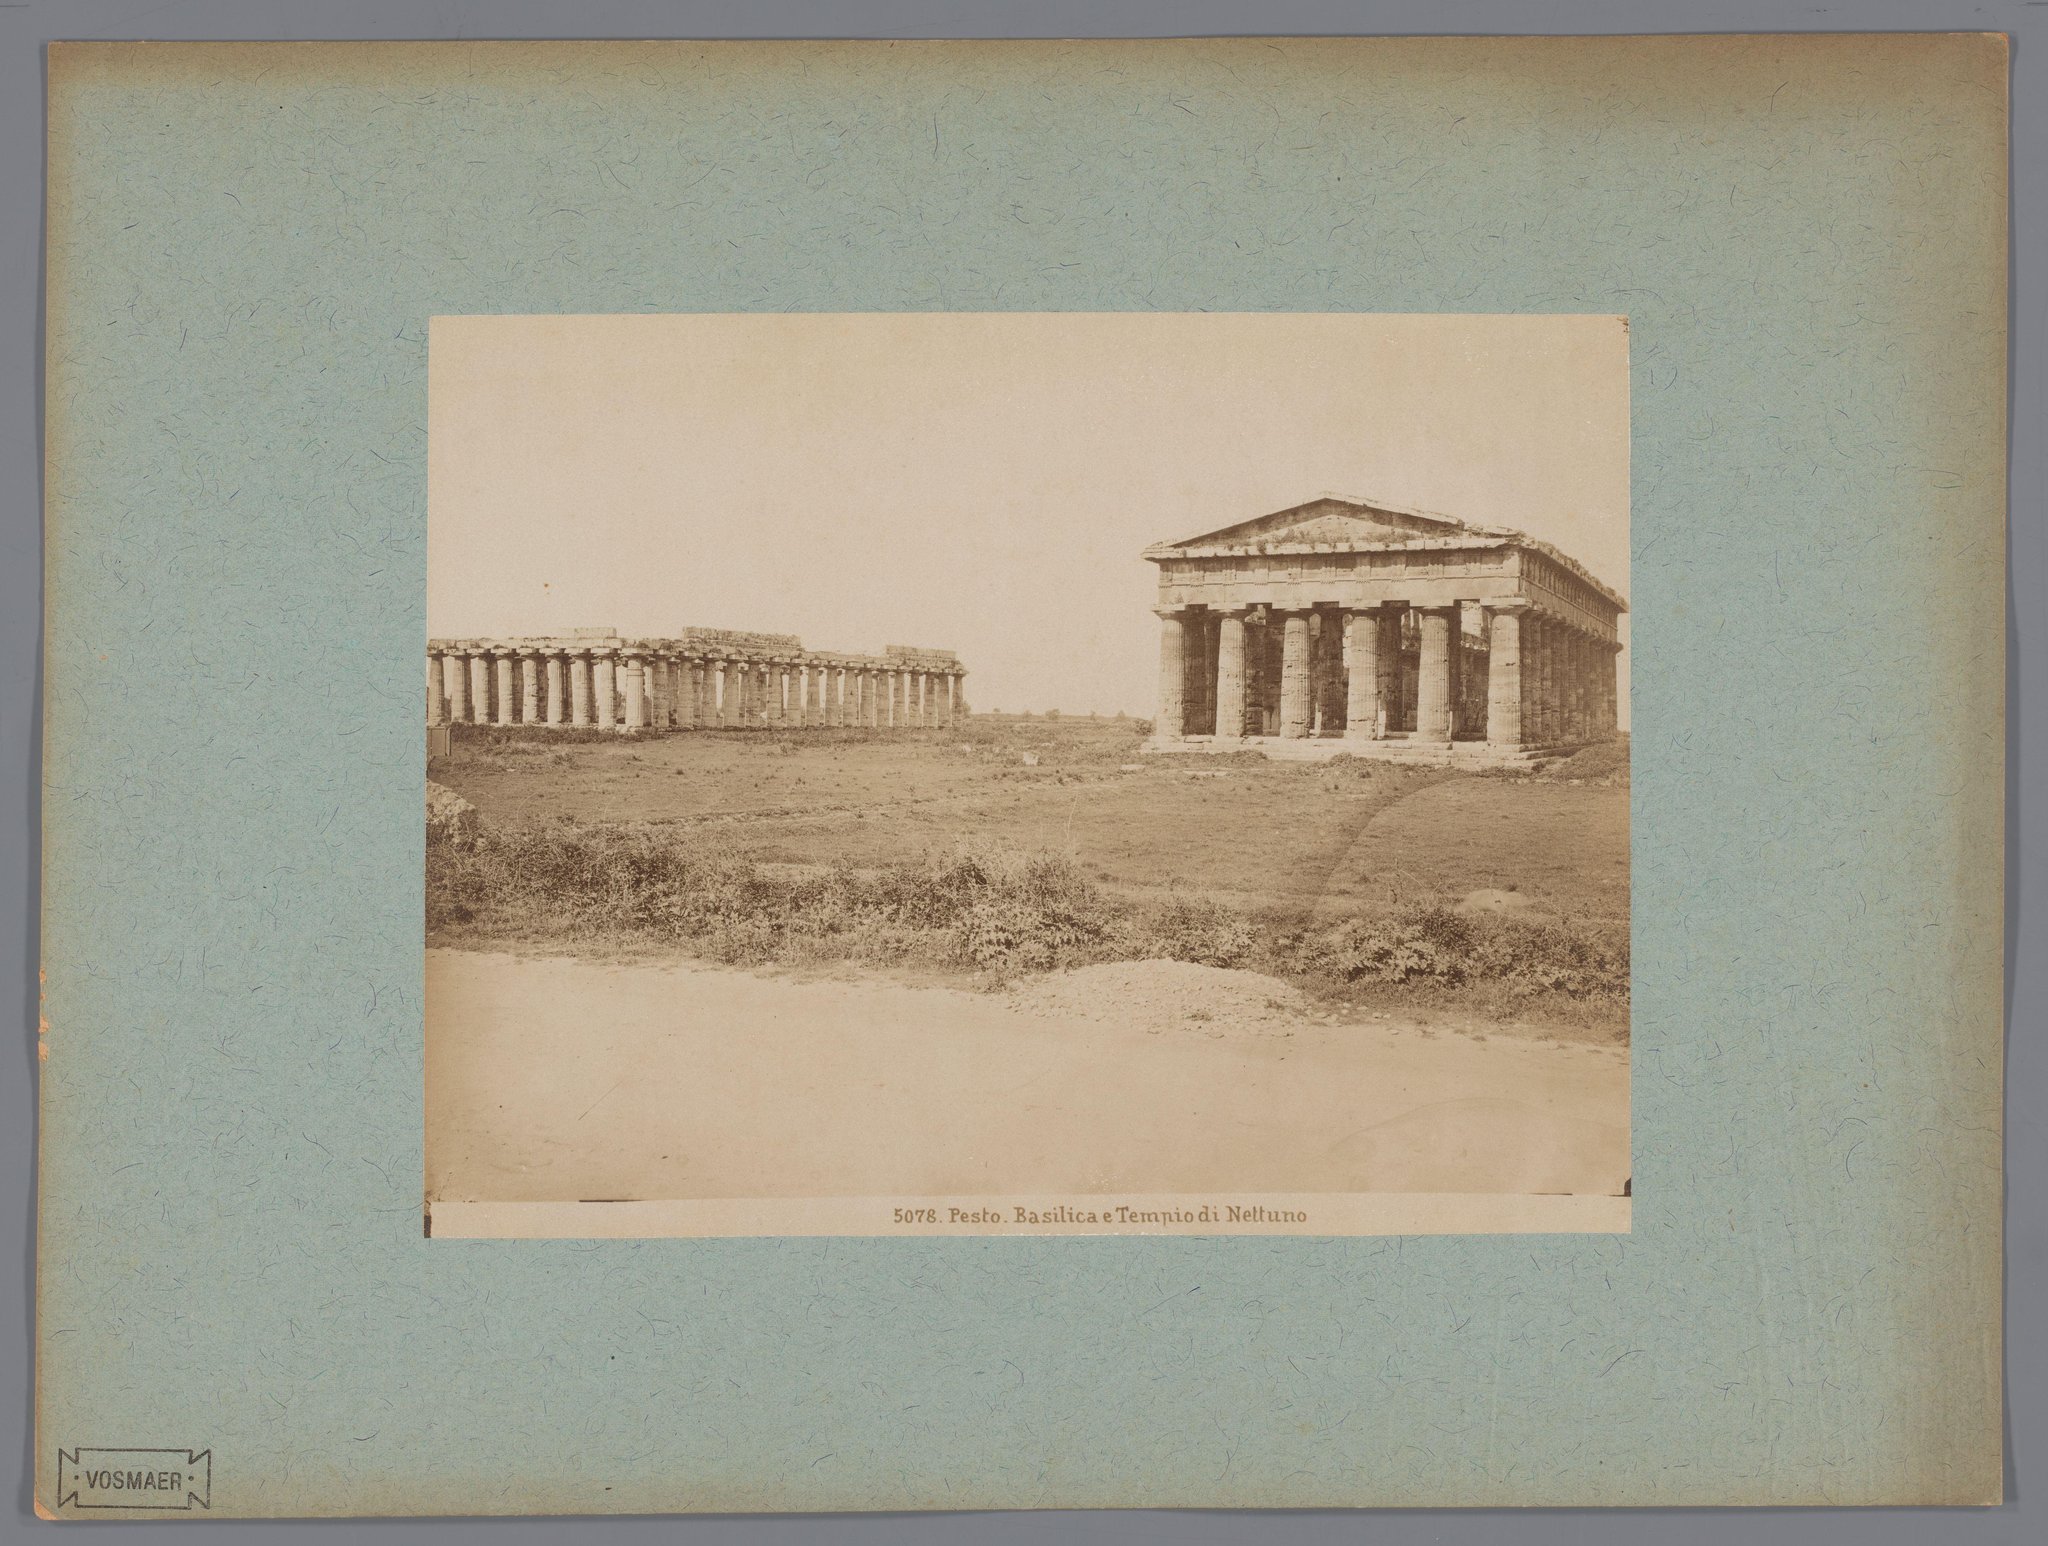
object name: photograph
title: Gezicht op de restanten van de Tempel van Neptunus te Paestum, Italië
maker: Anonymous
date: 1851-1900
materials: cardboard, paper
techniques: albumen print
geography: paestum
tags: ruin of a building ~ architecture, temple, shrine ~ greek religion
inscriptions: number: ‘5078.’, collector's mark: ‘VOSMAER’